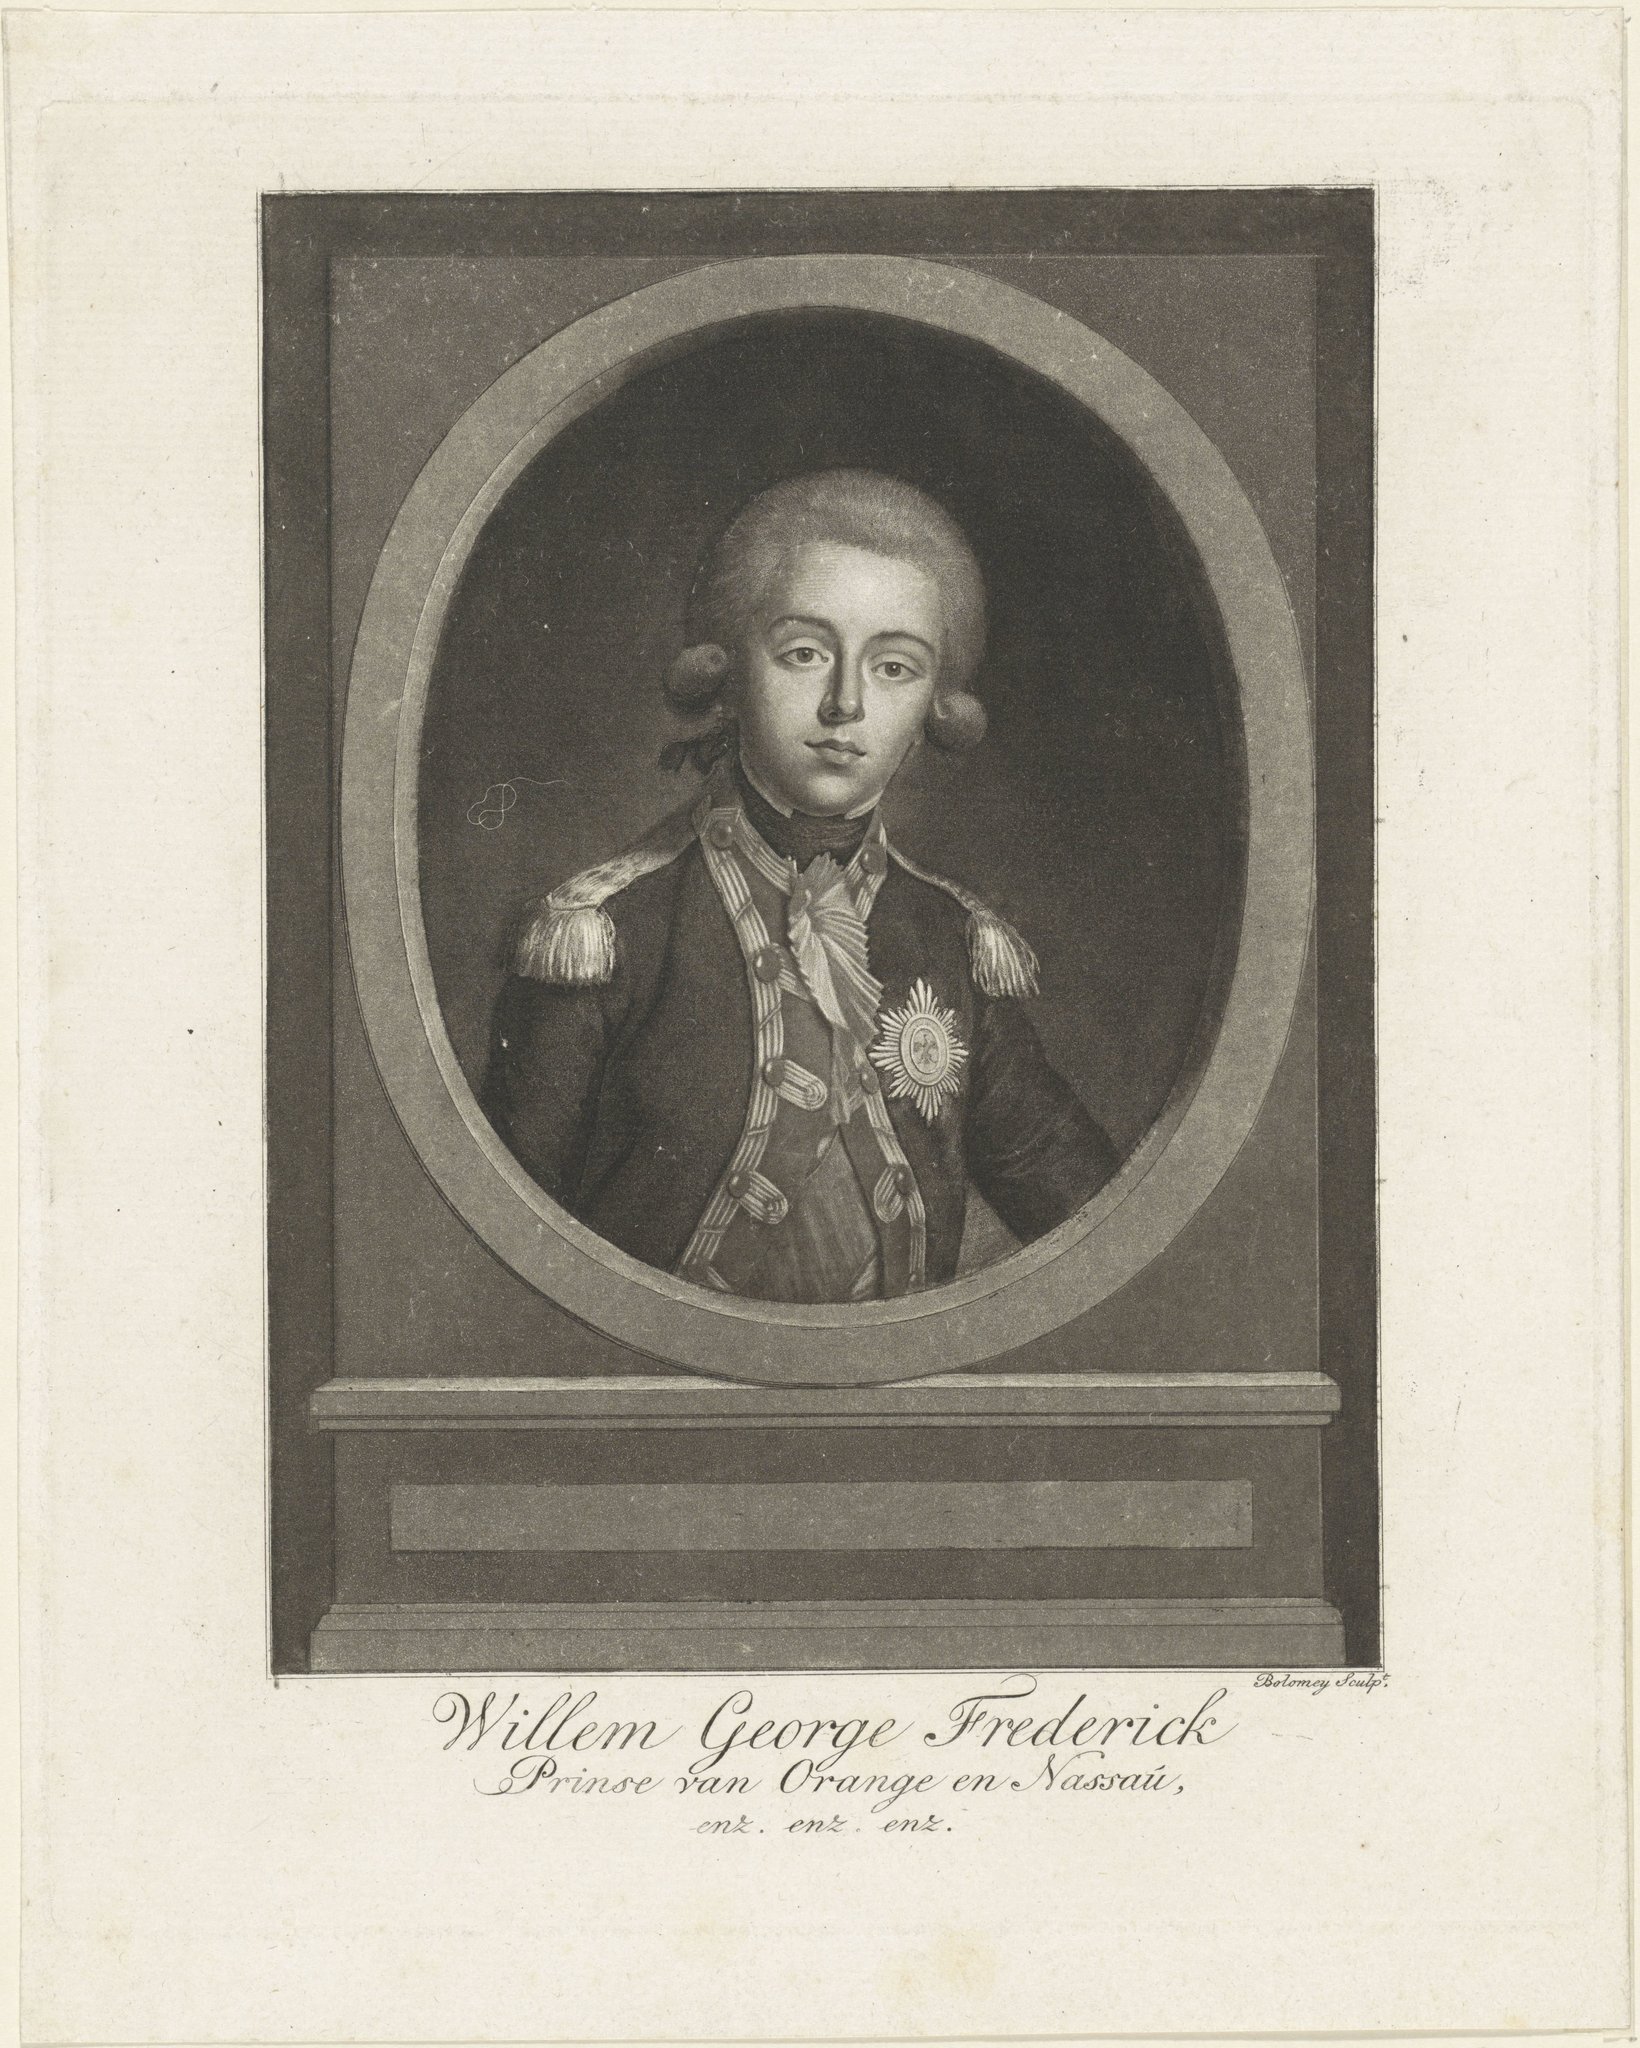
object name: print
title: Portret van Frederik, prins van Oranje-Nassau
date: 1790-1819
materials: paper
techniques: aquatint, etching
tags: the hague, willem george frederik (prins van oranje-nassau), knighthood order (with name) - insignia of a knighthood order, e.g.: badge, chain (with name of order)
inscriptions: collector's mark: Lugt 963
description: De hier vermelde titel verwijst naar de hoogst verkregen titel van de geportretteerde, niet per se naar de titel die de geportretteerde op deze voorstelling draagt.